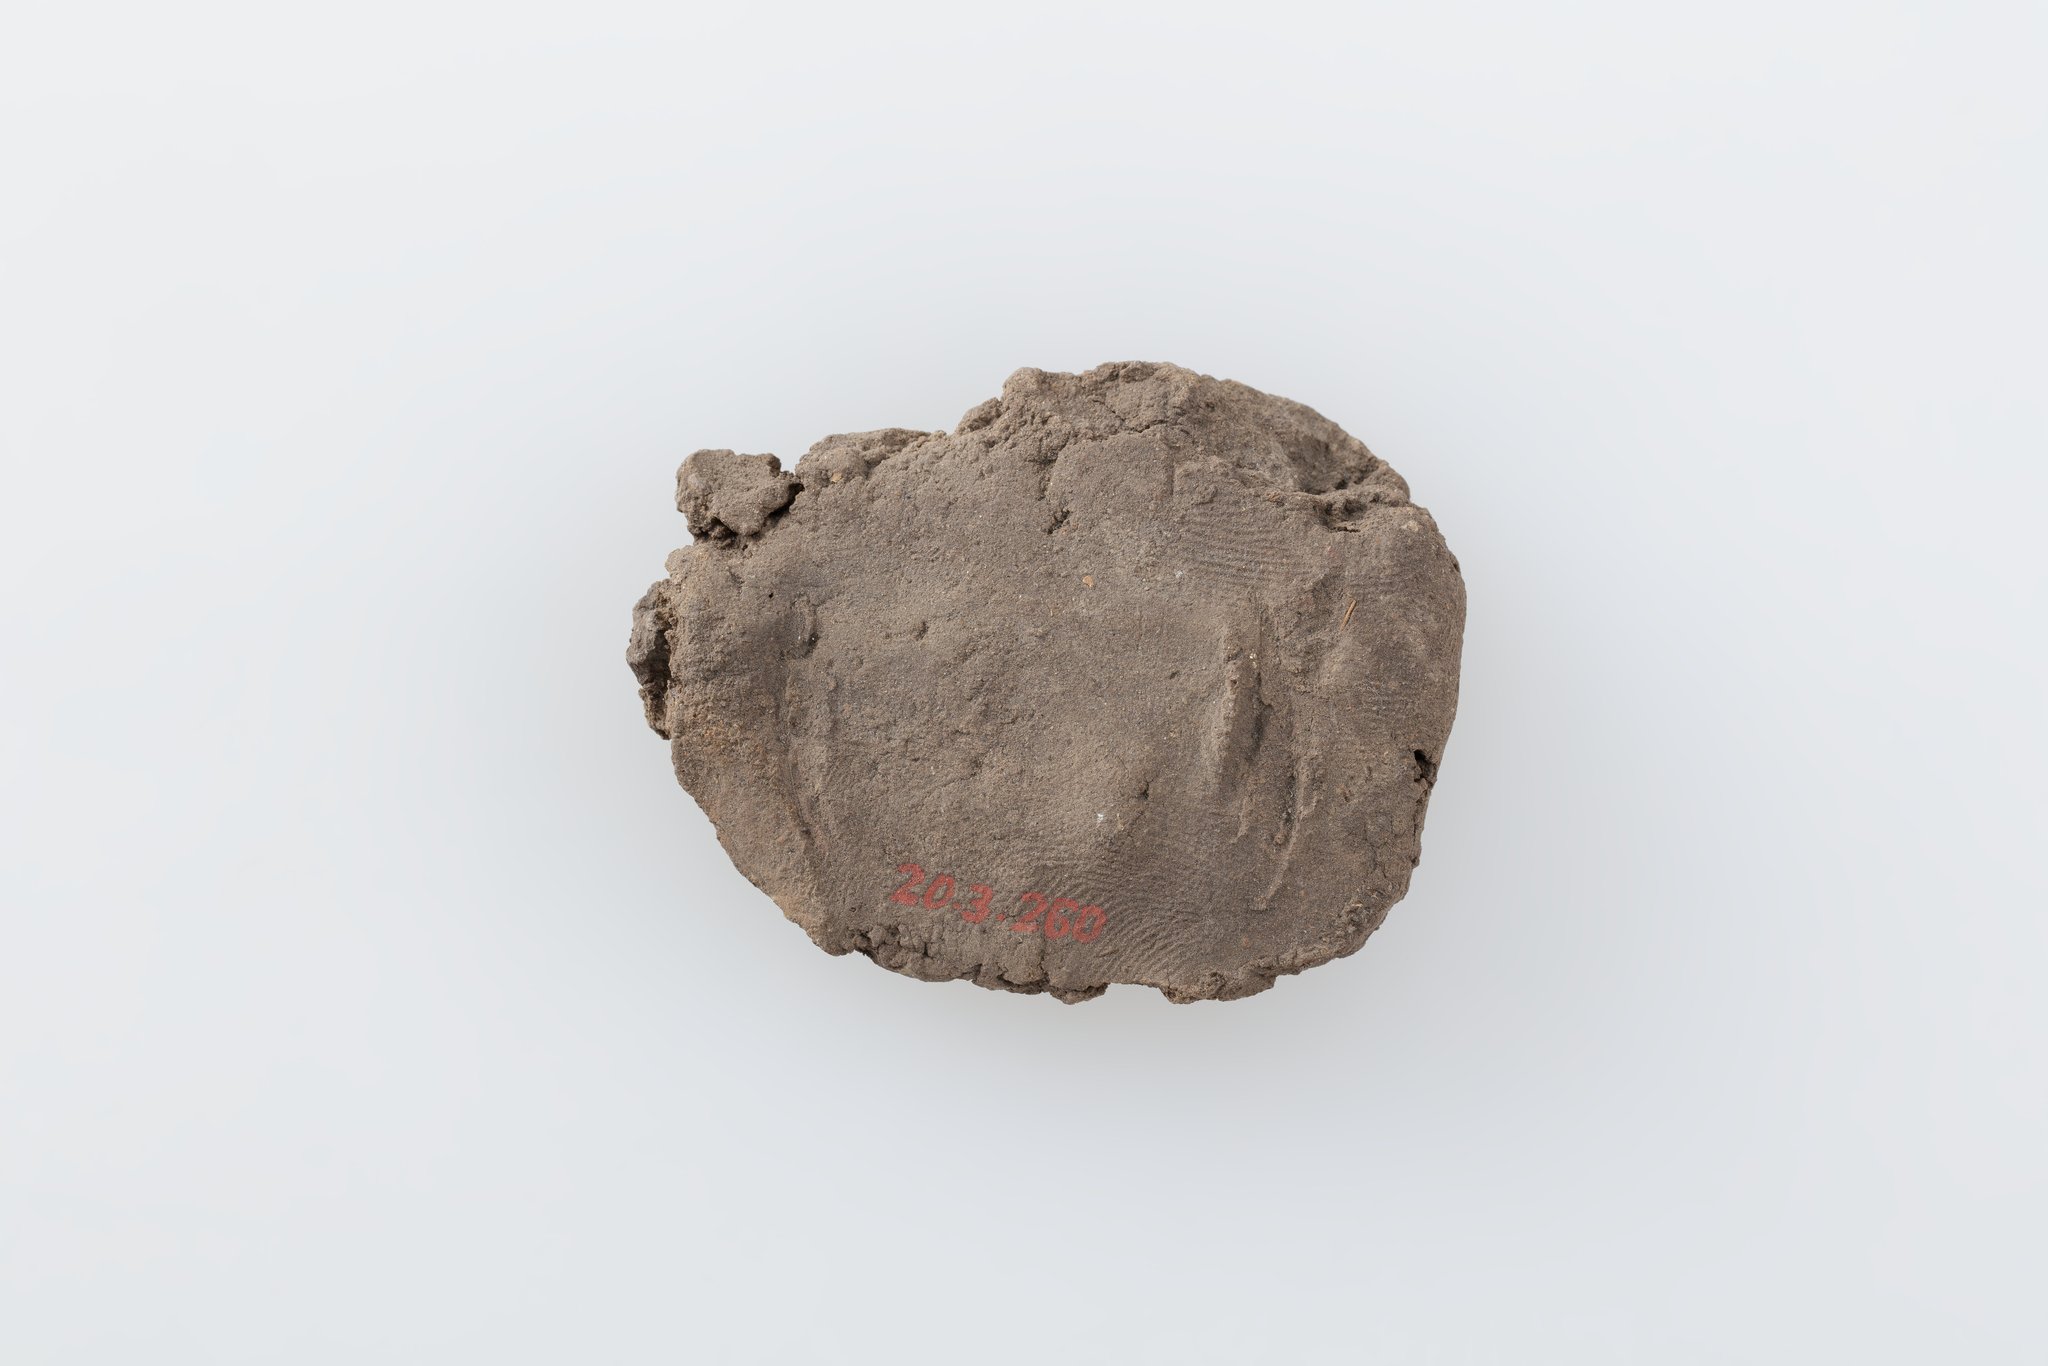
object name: model food offering, cake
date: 1981-1975 BCE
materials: mud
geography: egypt